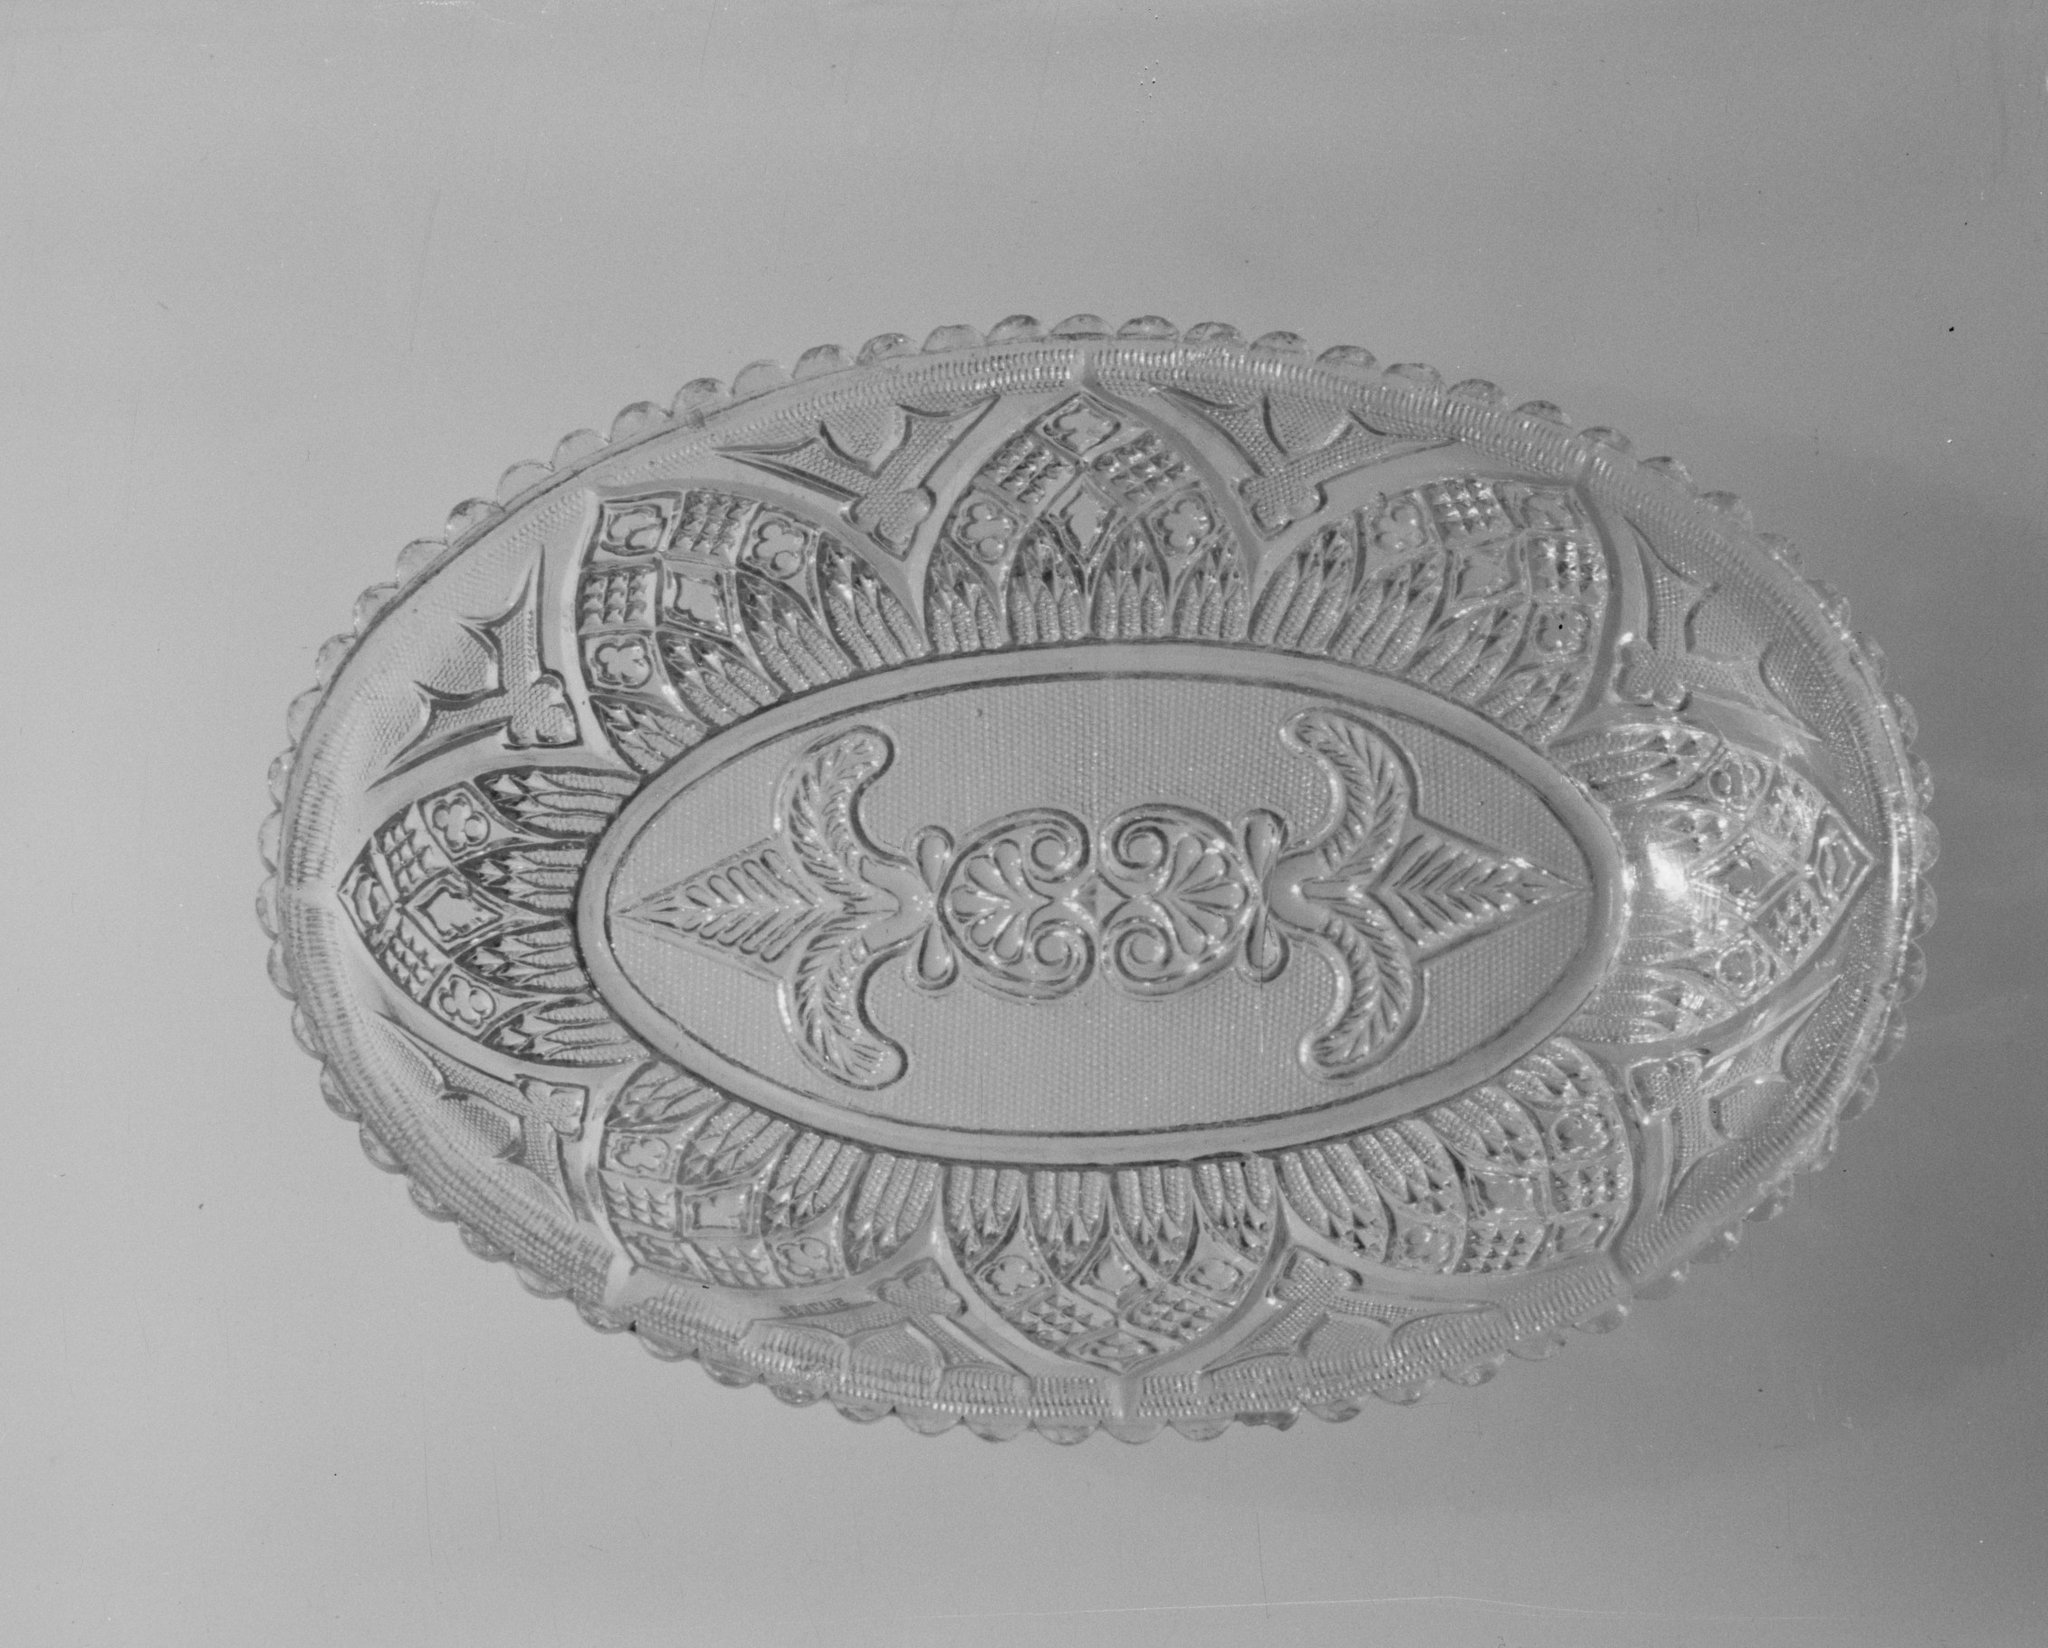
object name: dish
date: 1835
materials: glass